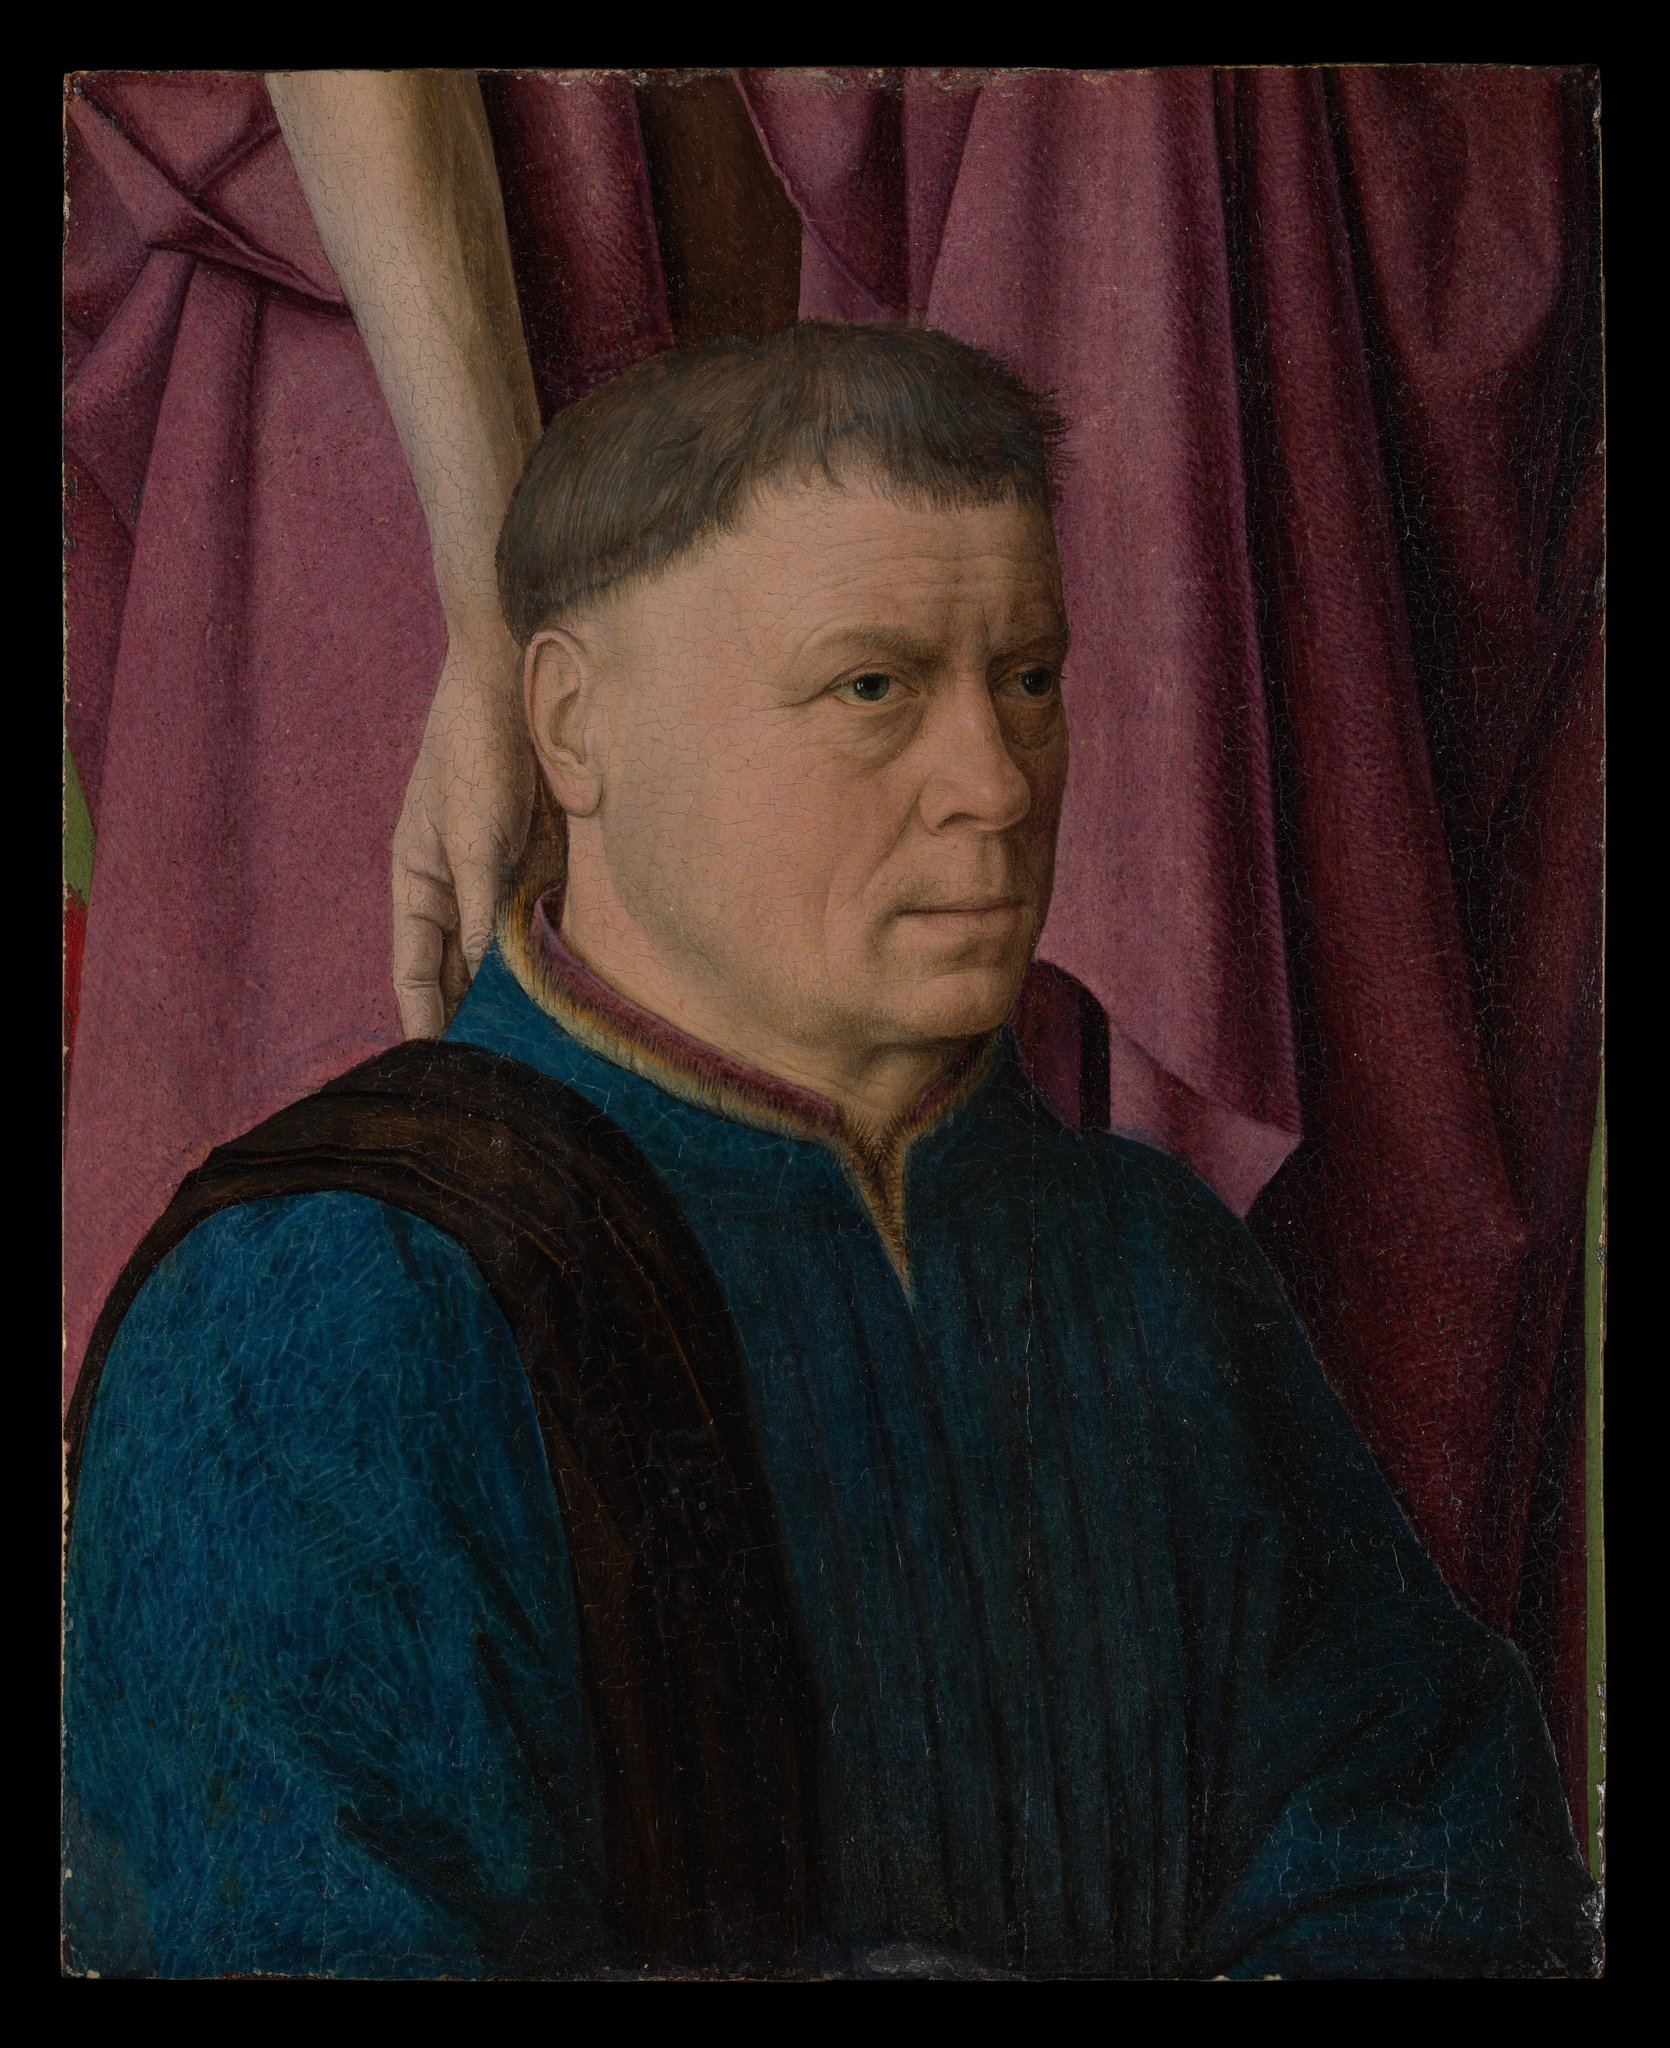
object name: painting fragment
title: A Donor Presented by a Saint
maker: dieric bouts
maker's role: artist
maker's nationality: netherlandish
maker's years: 1457-1475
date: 1460-1465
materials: oil, wood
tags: hands,men,portraits